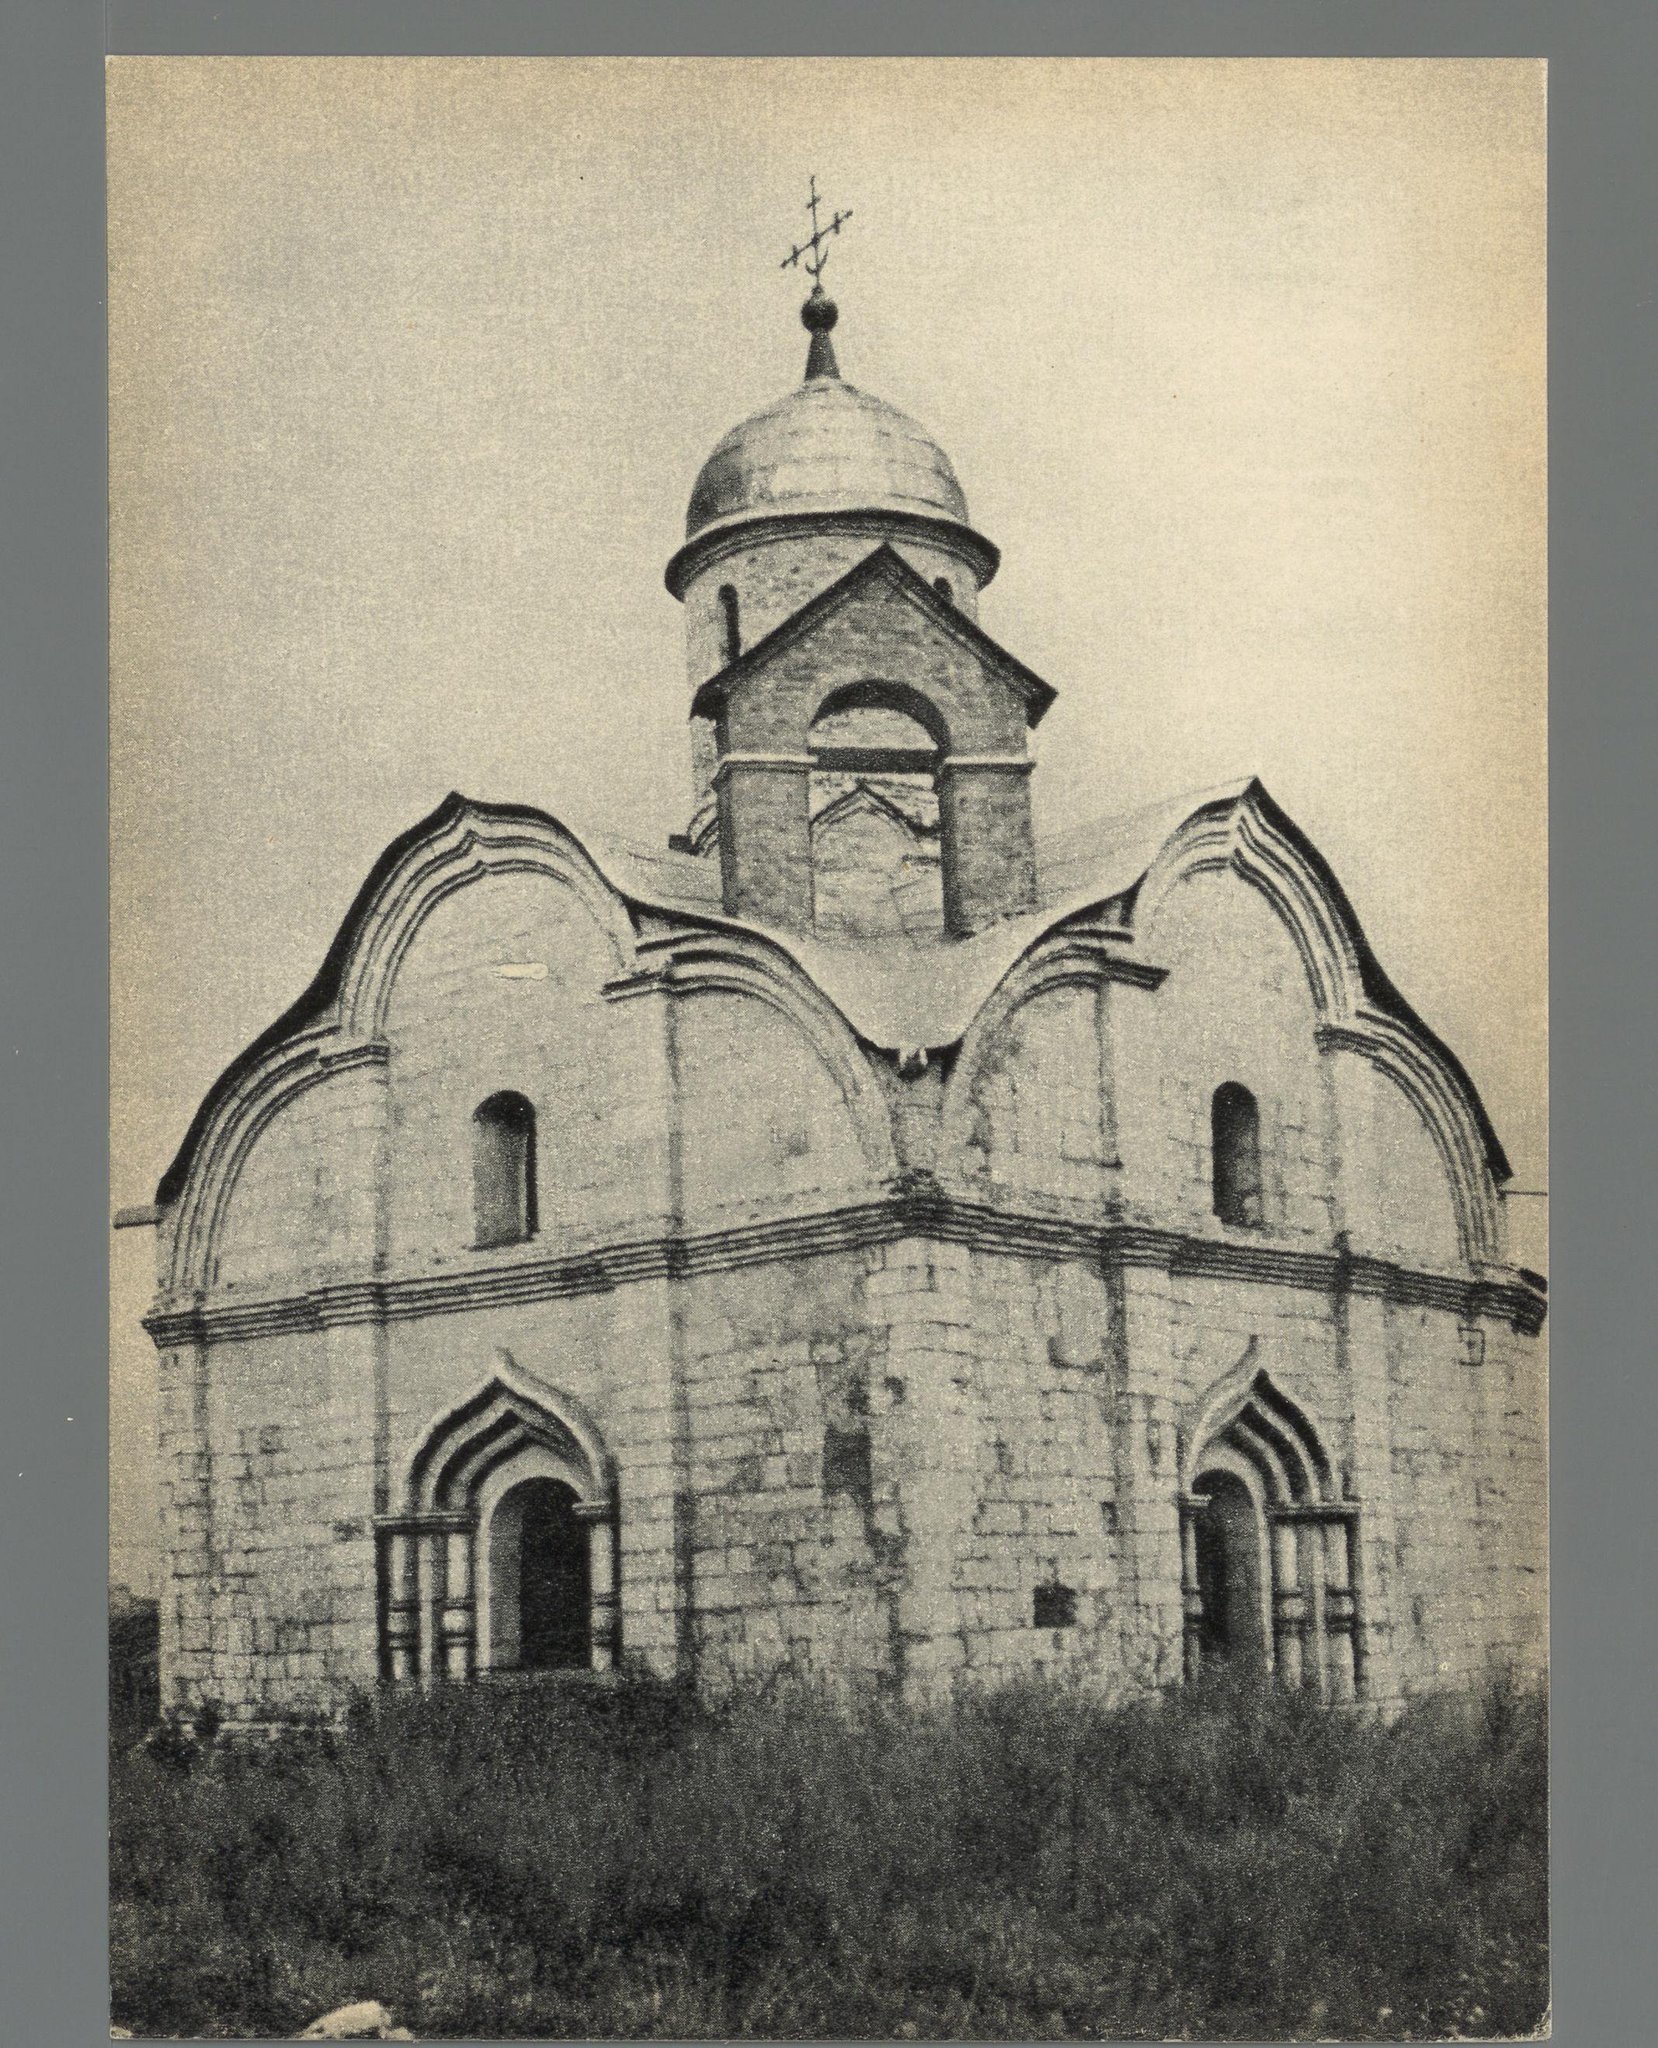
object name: photomechanical print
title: Gezicht op de Tryphonkerk te Naprudny, Moskou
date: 1957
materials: cardboard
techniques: rotogravure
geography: moscow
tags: church (exterior)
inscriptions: date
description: De titel op object staat in het Russisch.